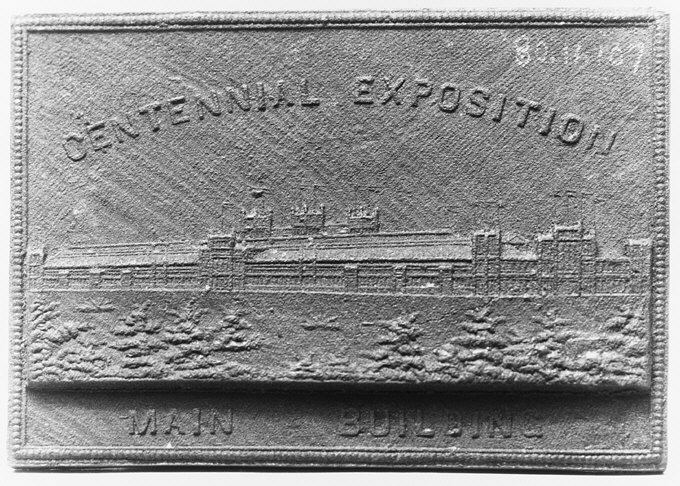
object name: plaque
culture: american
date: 1876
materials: wood